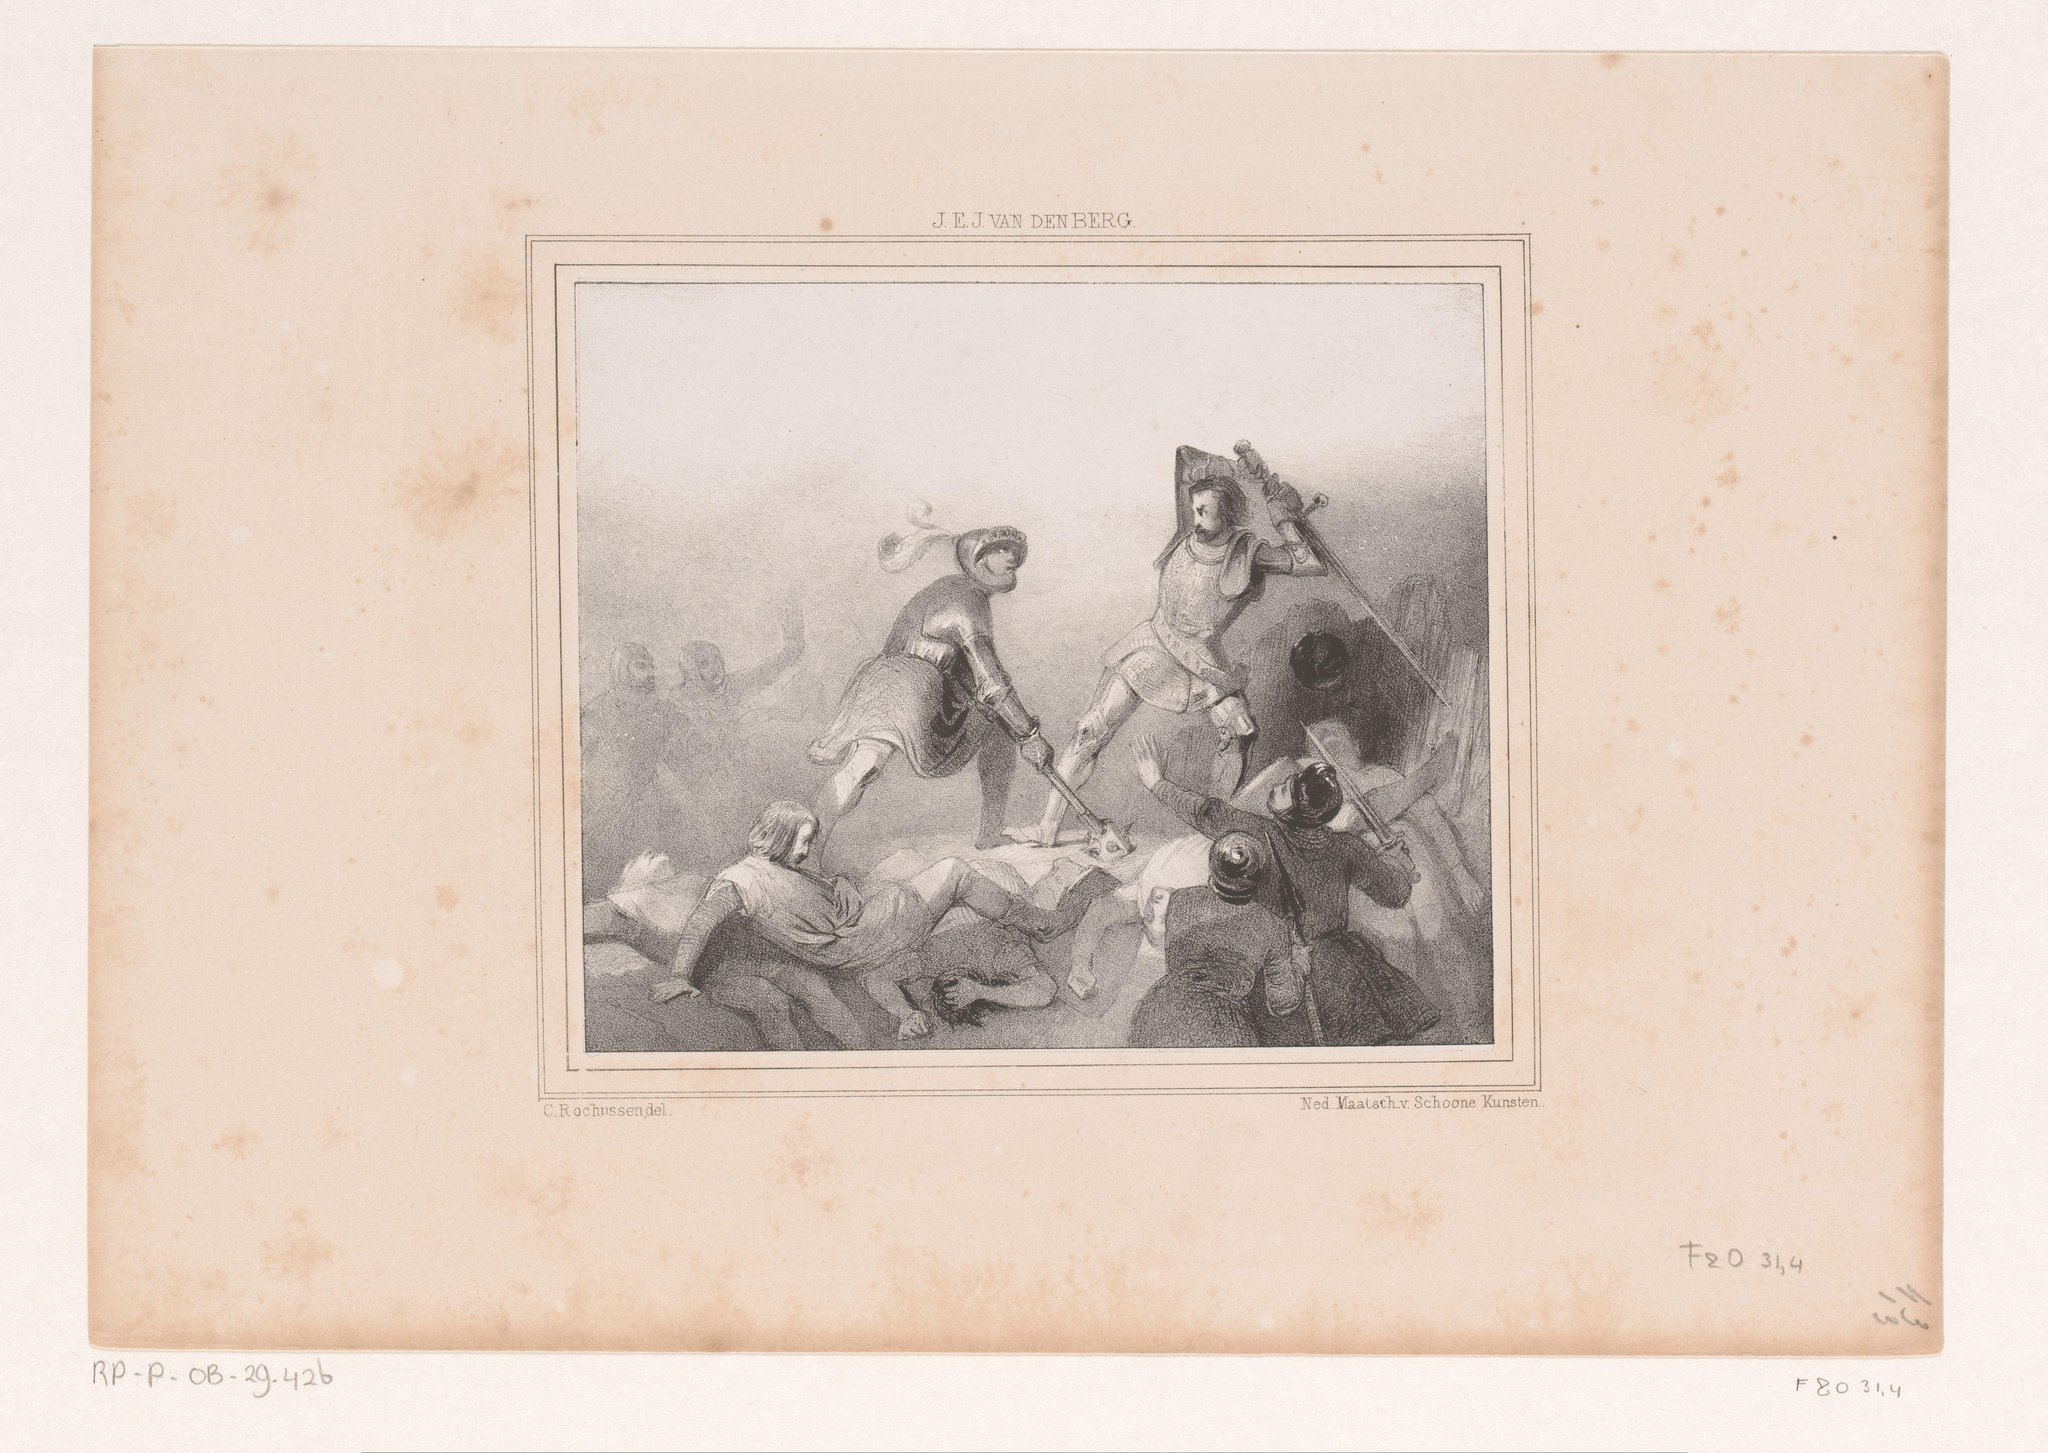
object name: print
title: Dood van Frison Seerp Adelen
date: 1842-1843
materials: paper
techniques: lithograph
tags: violent death, being killed; being mishandled and maltreated; seeking death, fighting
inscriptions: collector's mark: Lugt 2228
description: Twee mannen met zwaard en knots in gevecht. Omstanders kijken toe. Naar de roman De Roos van Dekama door Jacob van Lennep.